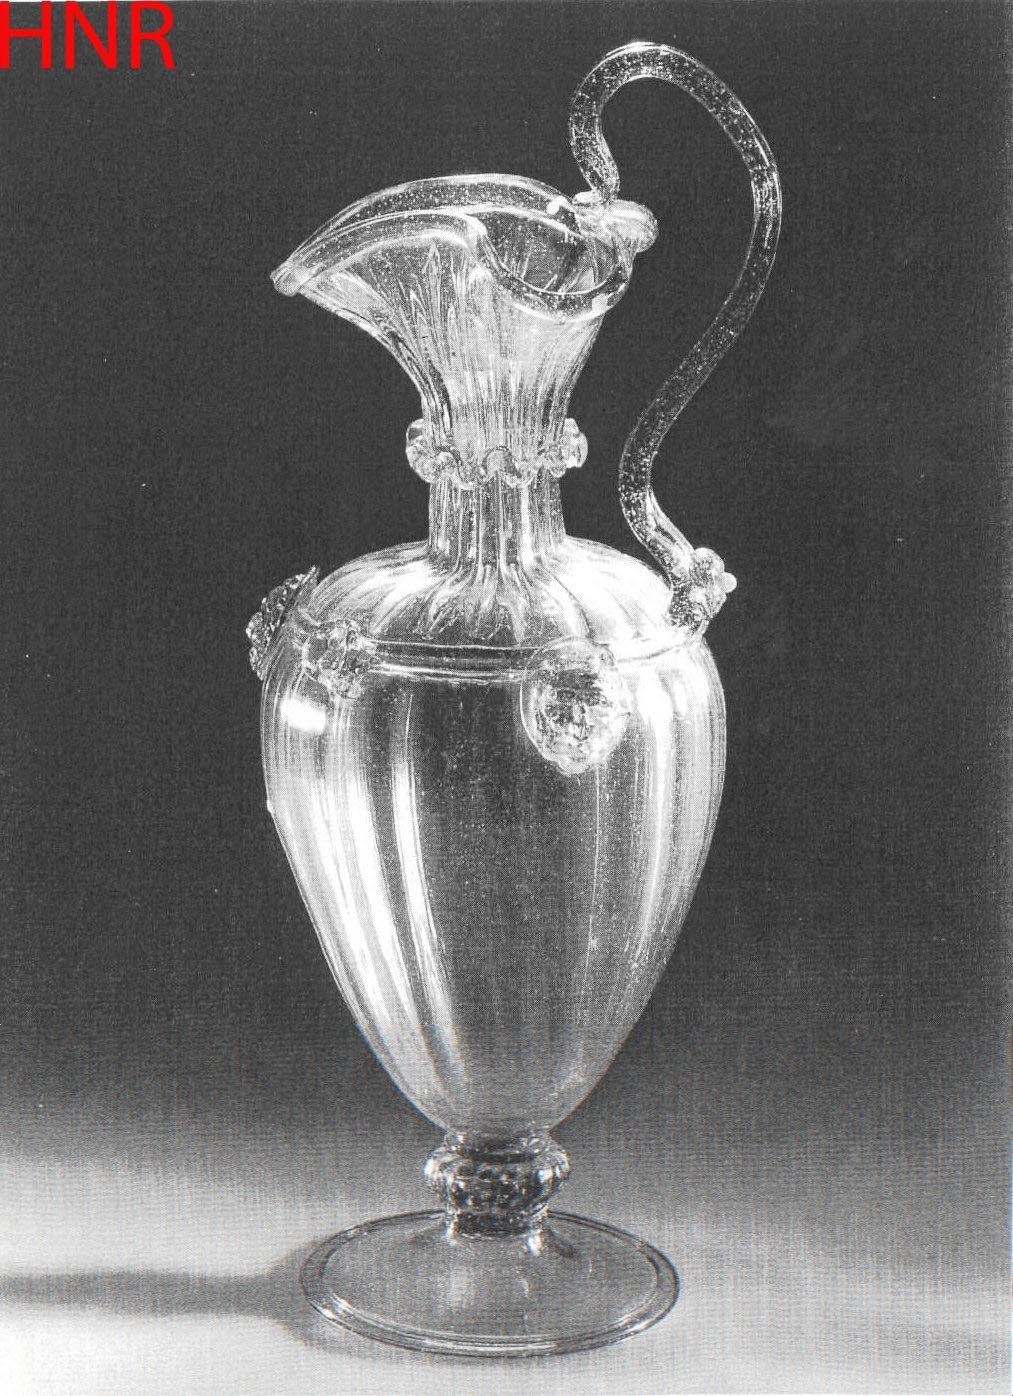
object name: ewer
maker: Anonymous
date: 1570-1600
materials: glass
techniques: façon de venise, gilding, glassblowing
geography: netherlands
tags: mask, mascaron ~ ornament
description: Glas à la façon de Venise. Platte voet met omgeslagen rand. De stam gevormd door een holle, geribde nodus. Het eivormige lichaam, de hals die uitloopt in een klaverbladvormige mond,en het S-vormige oor verticaal geribd. Op de schouder een gladde draad met drie mascarons en drie noppen met turkoois hart, om de hals een gegolfde draad, de mond afgezet met een gladde draad.